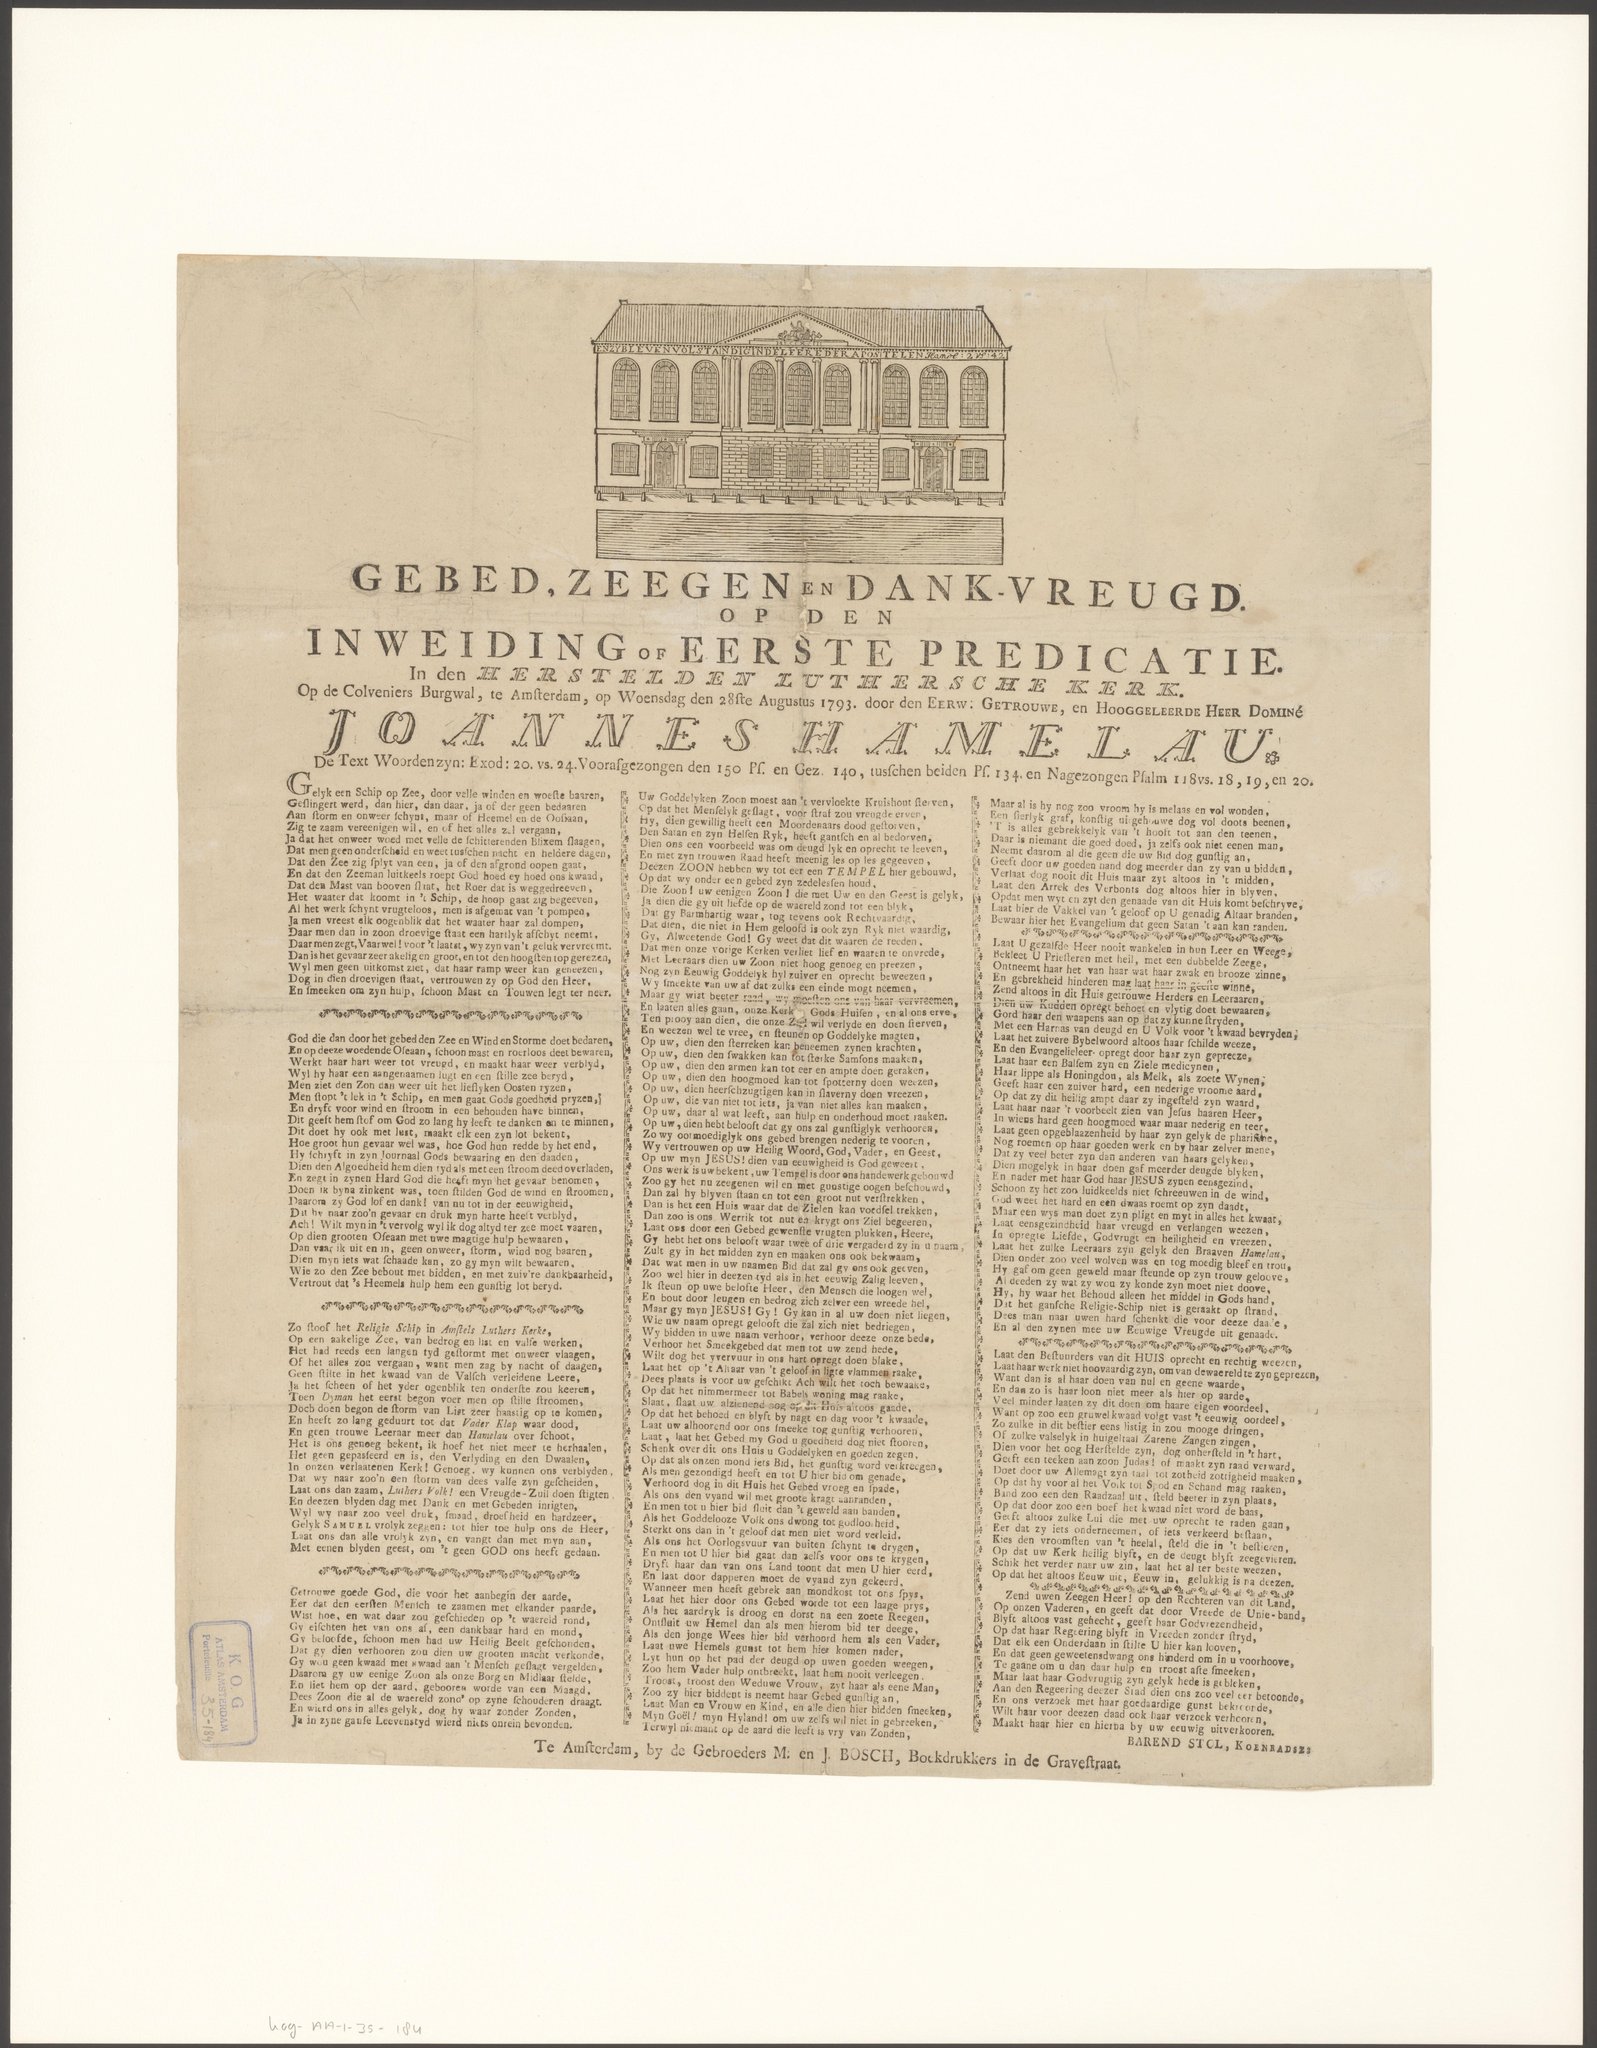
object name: text sheet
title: Gebed, zeegen en dank-vreugd. Op den inweiding of eerste predicatie (...)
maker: Anonymous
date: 1792-1793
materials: paper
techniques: letterpress printing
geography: amsterdam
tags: protestant churches and denominations (lutherans), church (exterior)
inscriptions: collector's mark: Lugt 1641b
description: Rechtsonder genummerd: Bl. 322. Onderwerpsrubriek binnen de Atlas Amsterdam: Kerkwezen: Ev. Lutherse Gemeente: Herst. Ev. Luth. Gemeente.